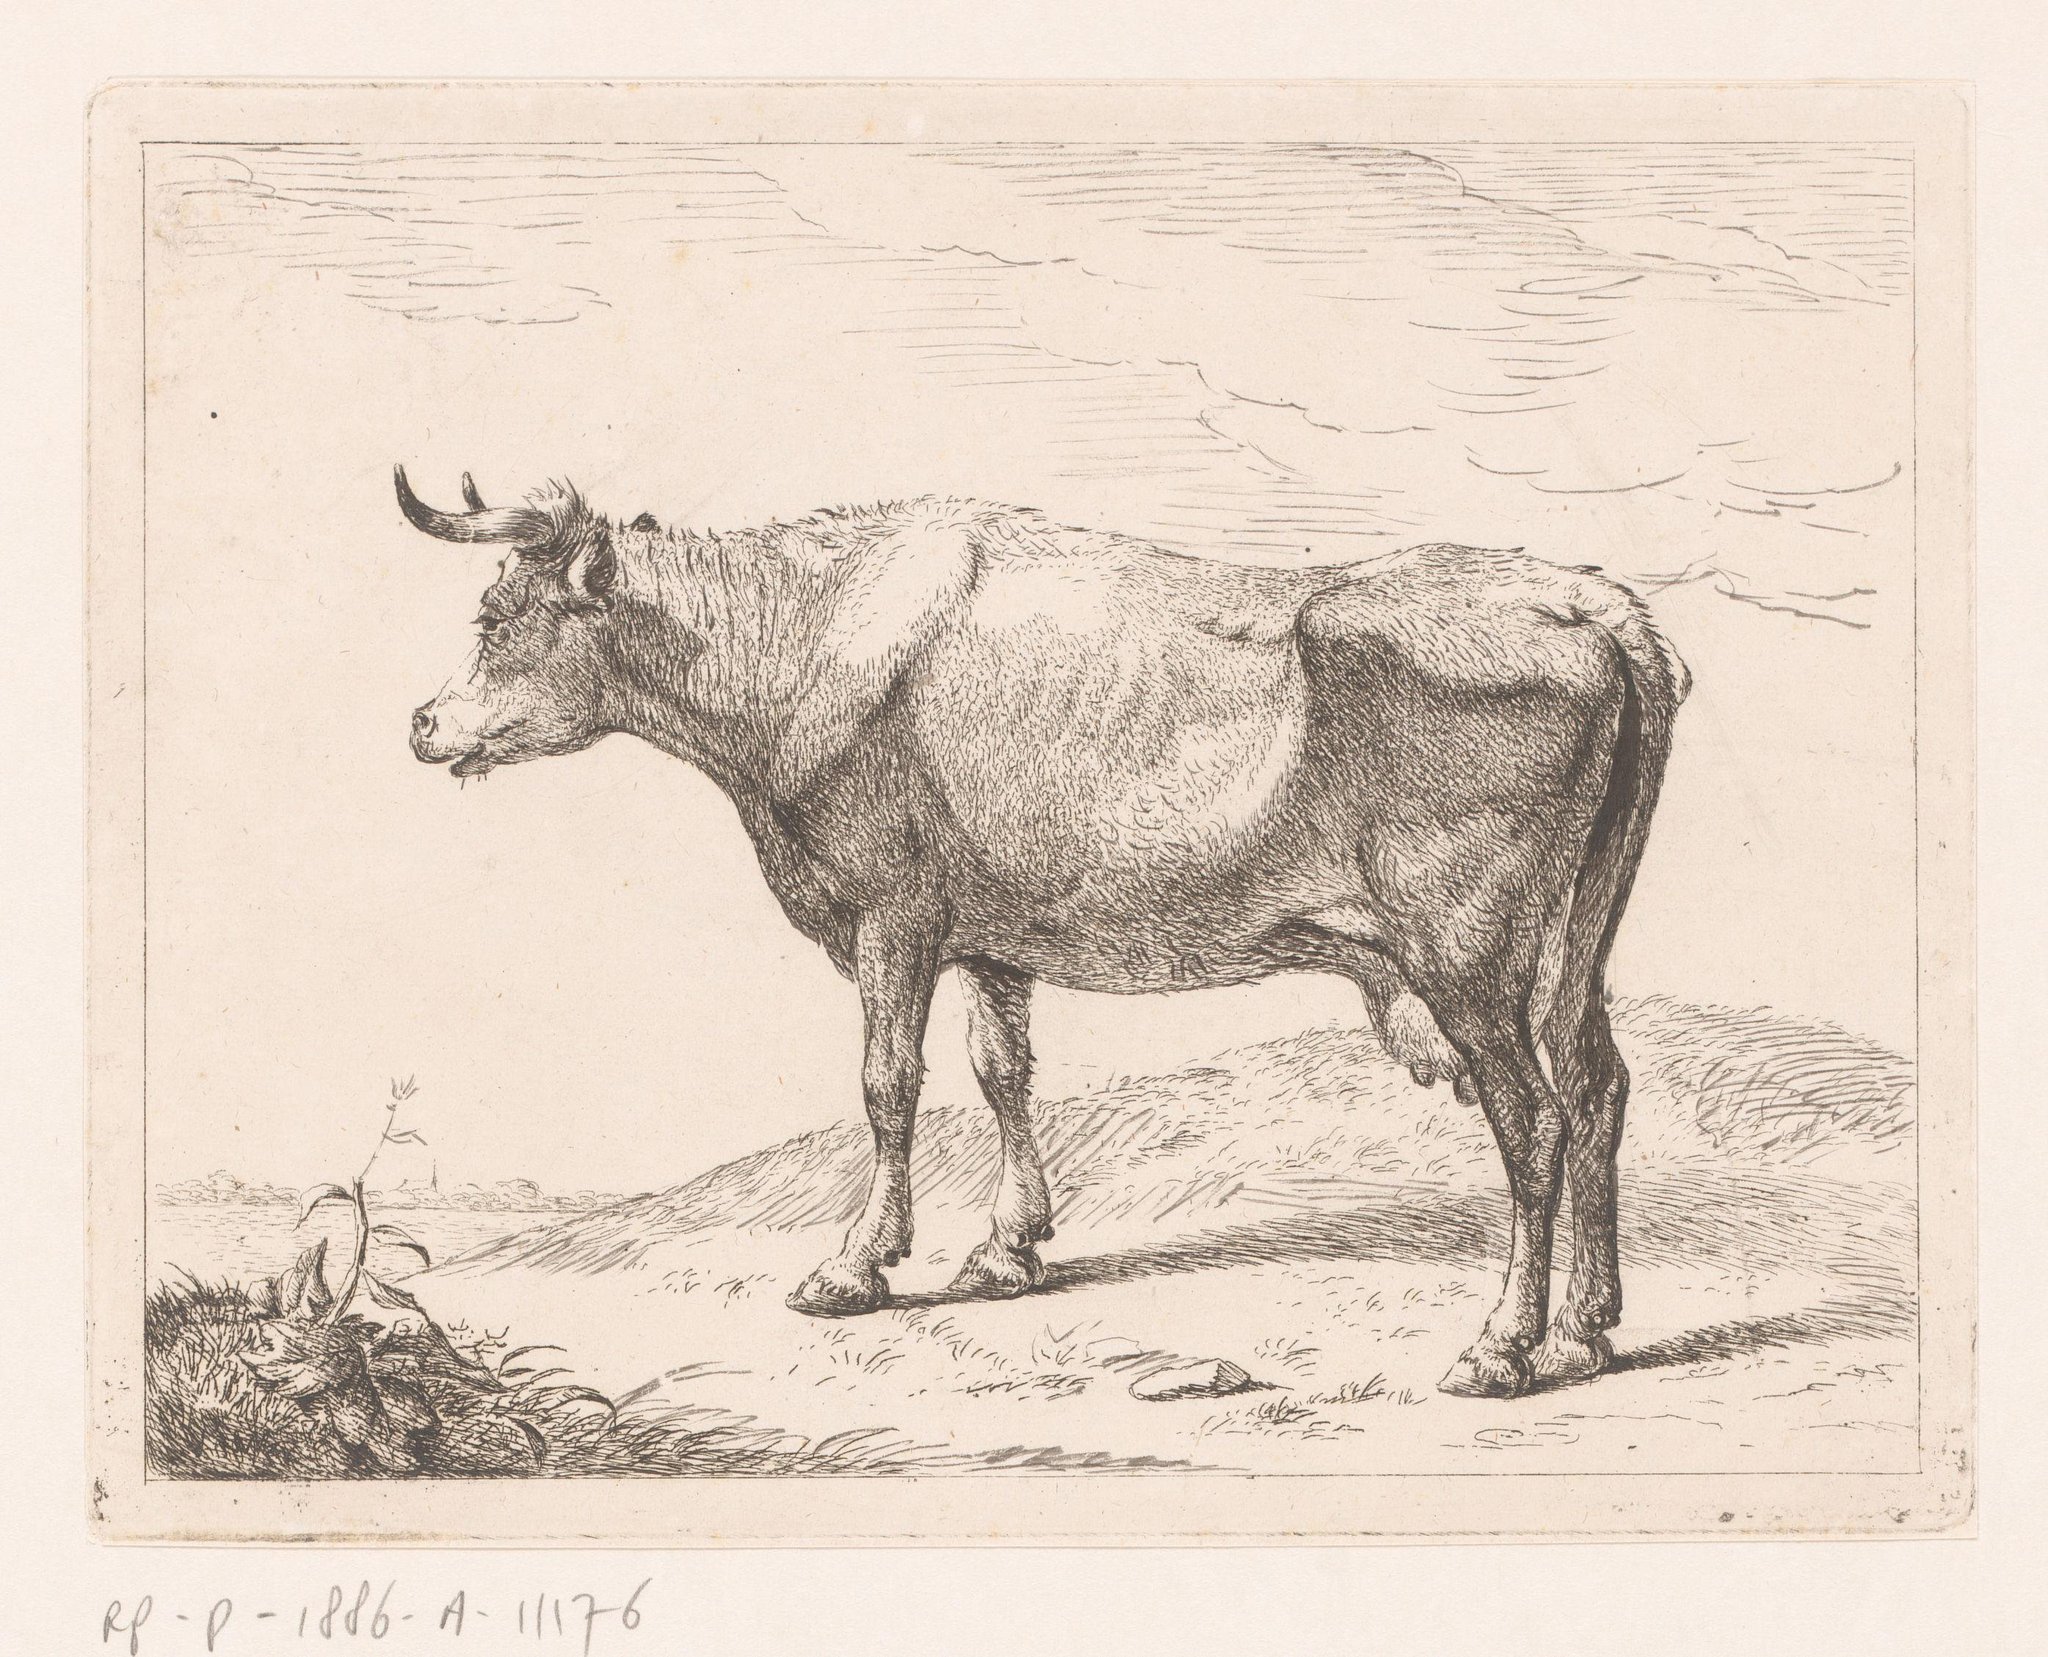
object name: print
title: Koe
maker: hendrik willem schweickhardt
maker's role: draughtsman, painter, print maker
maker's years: 1746-1797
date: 1788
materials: paper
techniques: etching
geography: england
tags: cow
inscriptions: collector's mark: Lugt 2228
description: Behoort tot een serie van acht prenten met verschillende dieren.